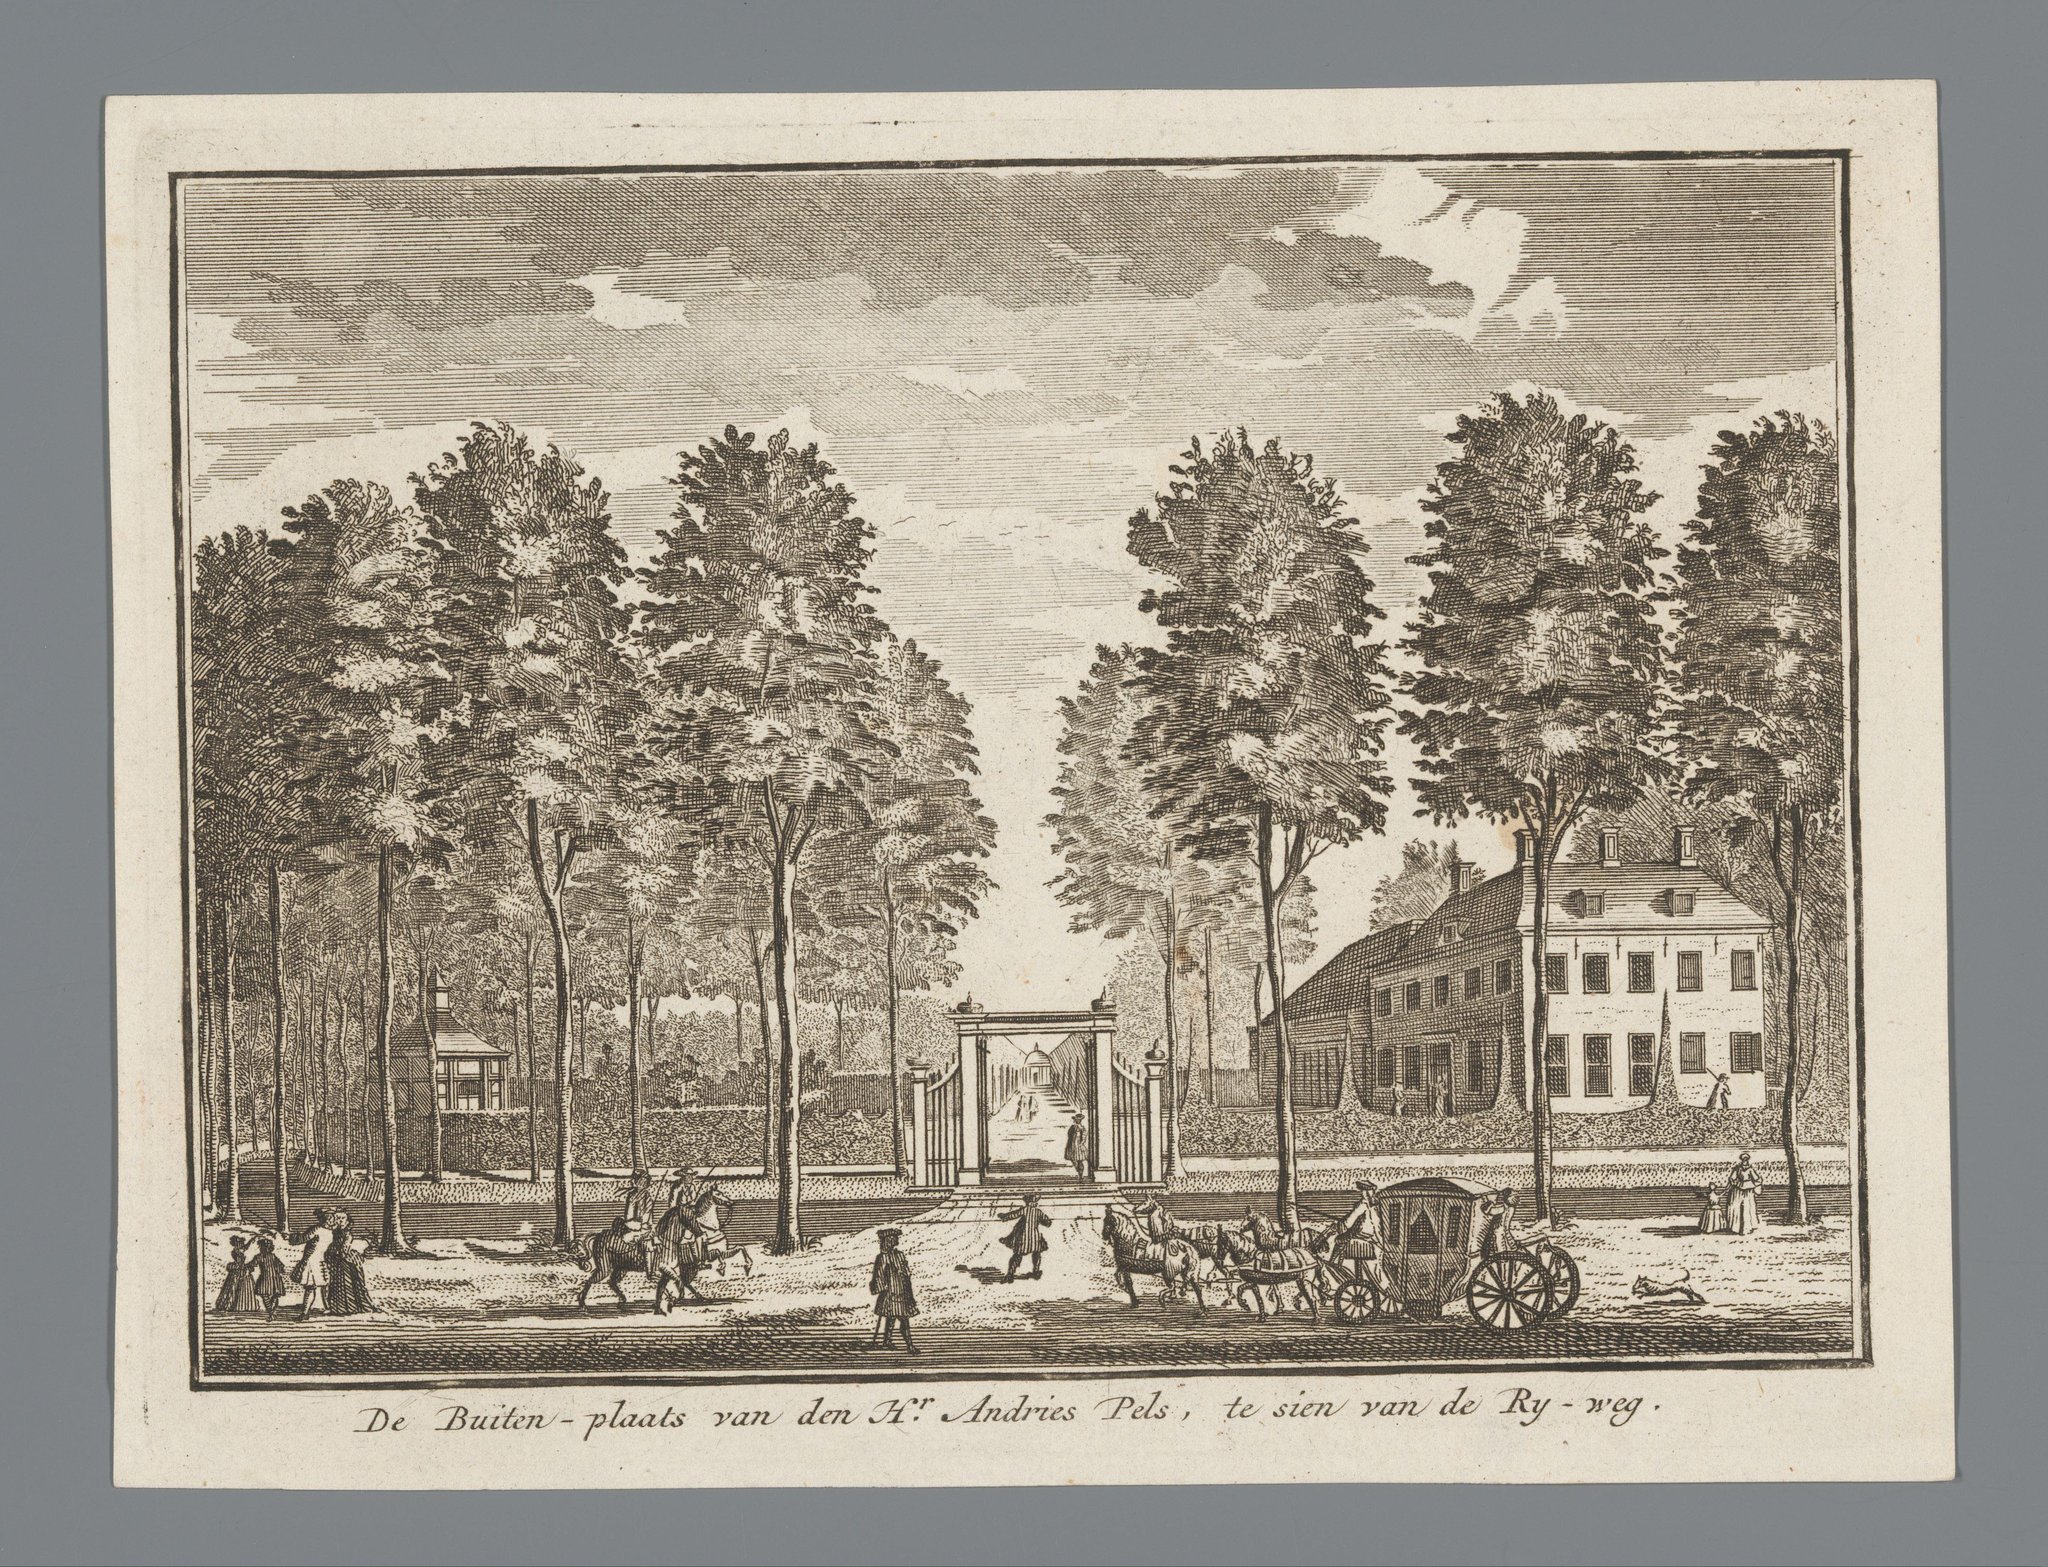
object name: print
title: De Buiten-plaats van den Hr. Andries Pels, te sien van de Ry-weg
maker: daniël stopendaal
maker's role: print maker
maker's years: 1672-1726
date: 1719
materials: paper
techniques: etching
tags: civic architecture; edifices; dwellings, netherlands